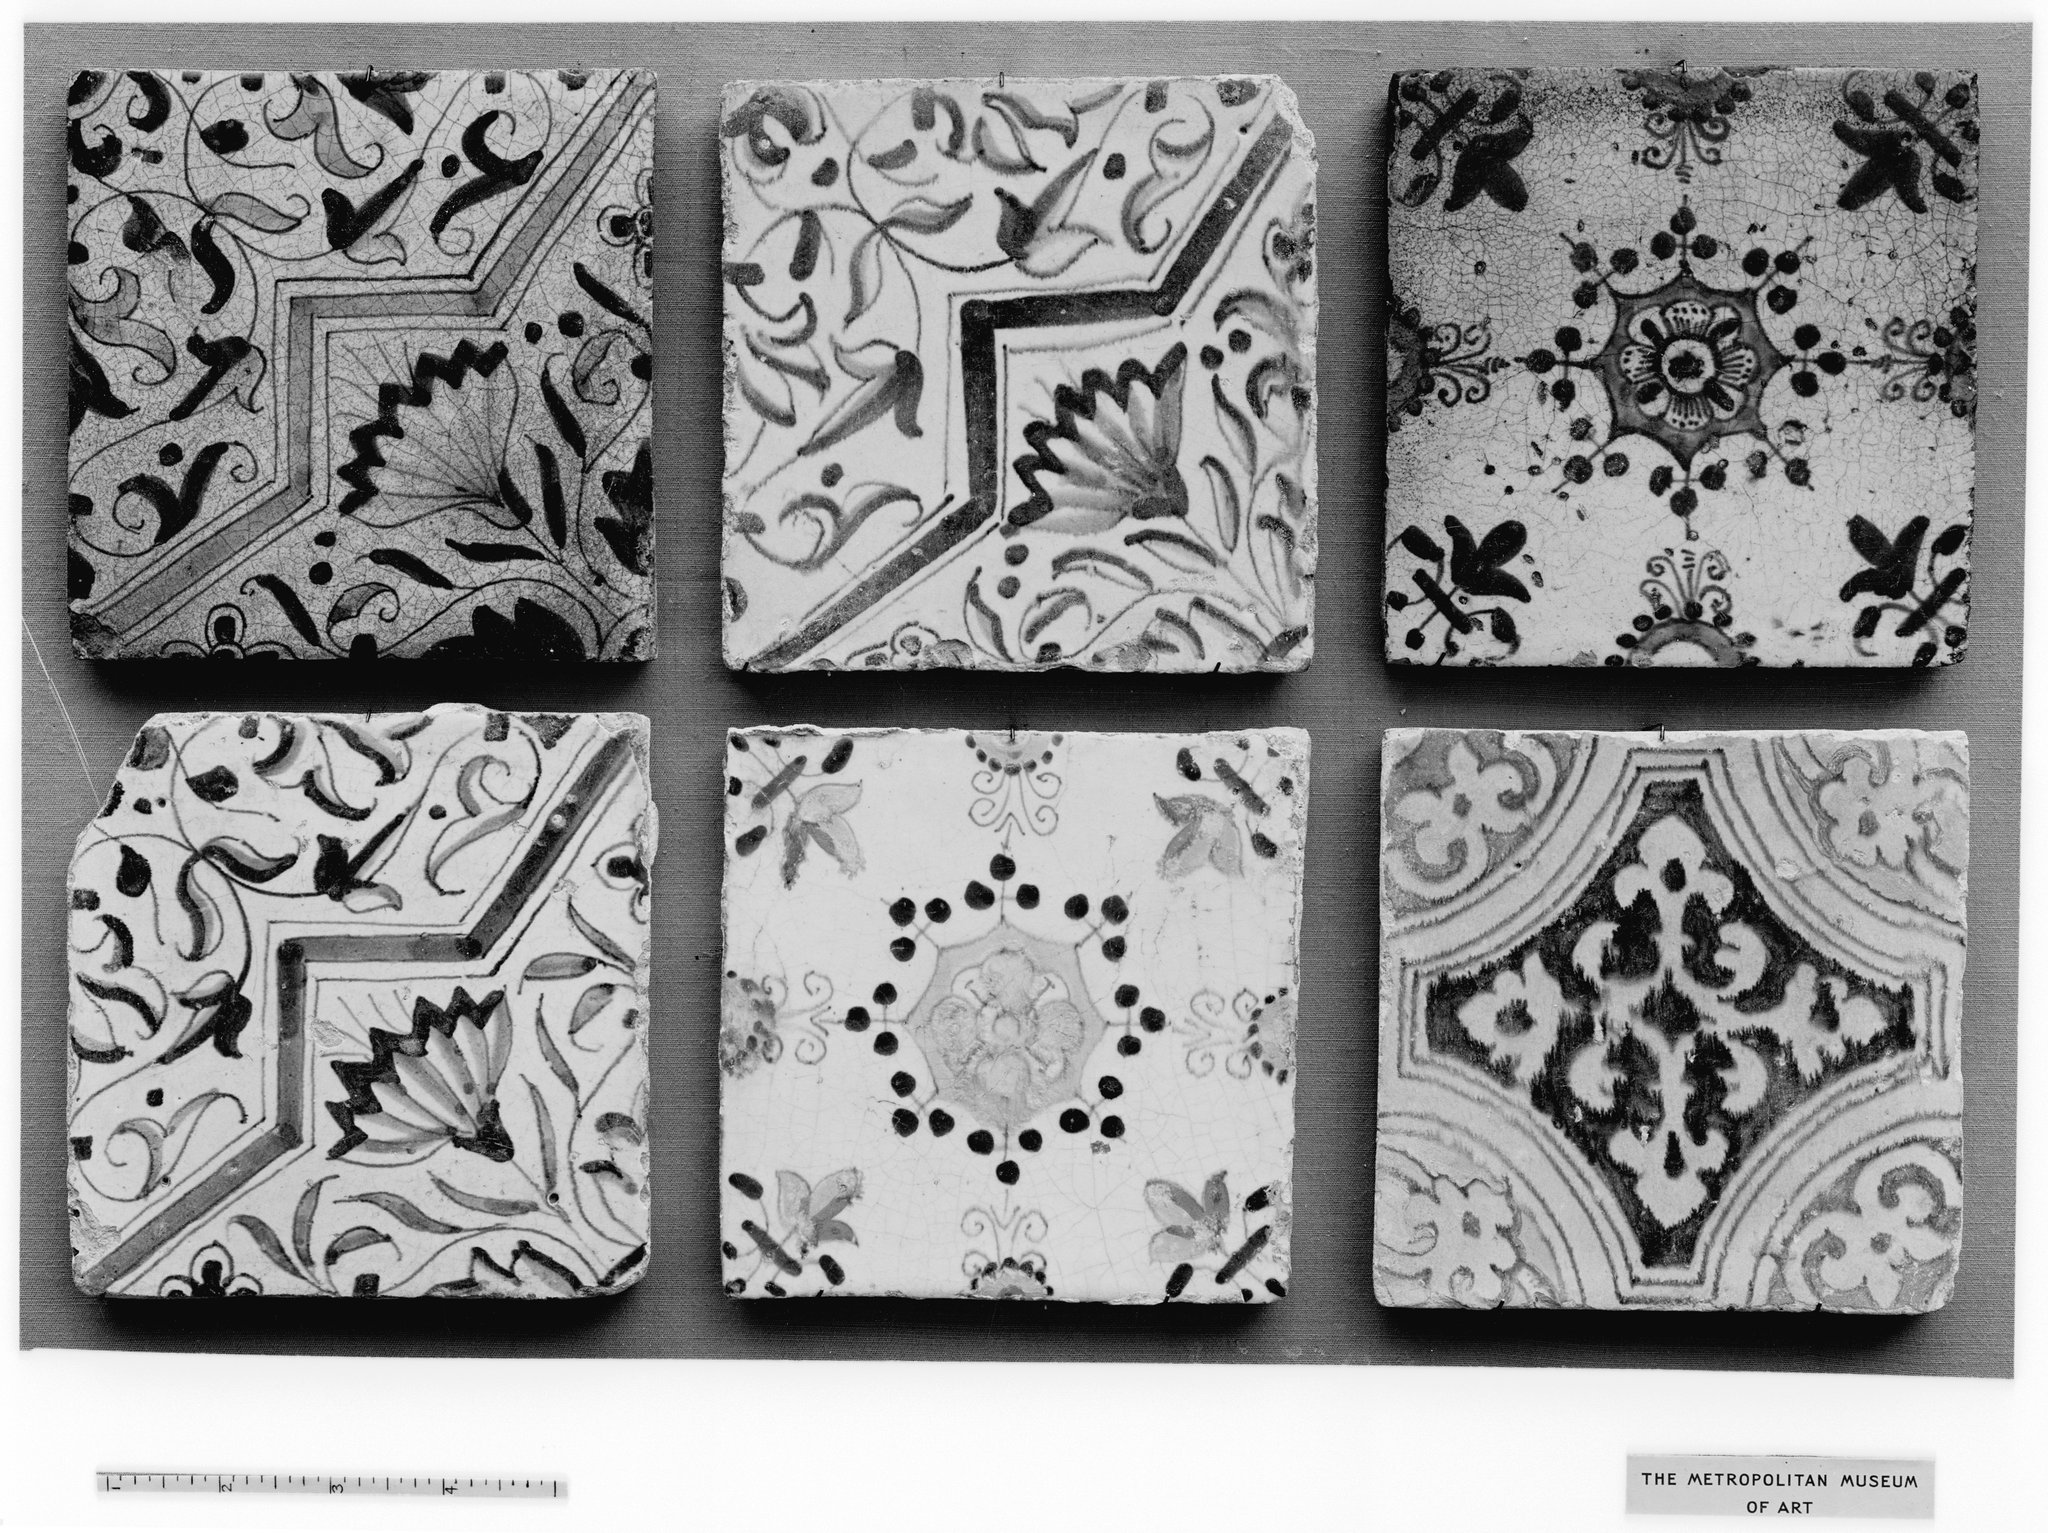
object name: tile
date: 1560-1600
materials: earthenware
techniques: glazing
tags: flowers